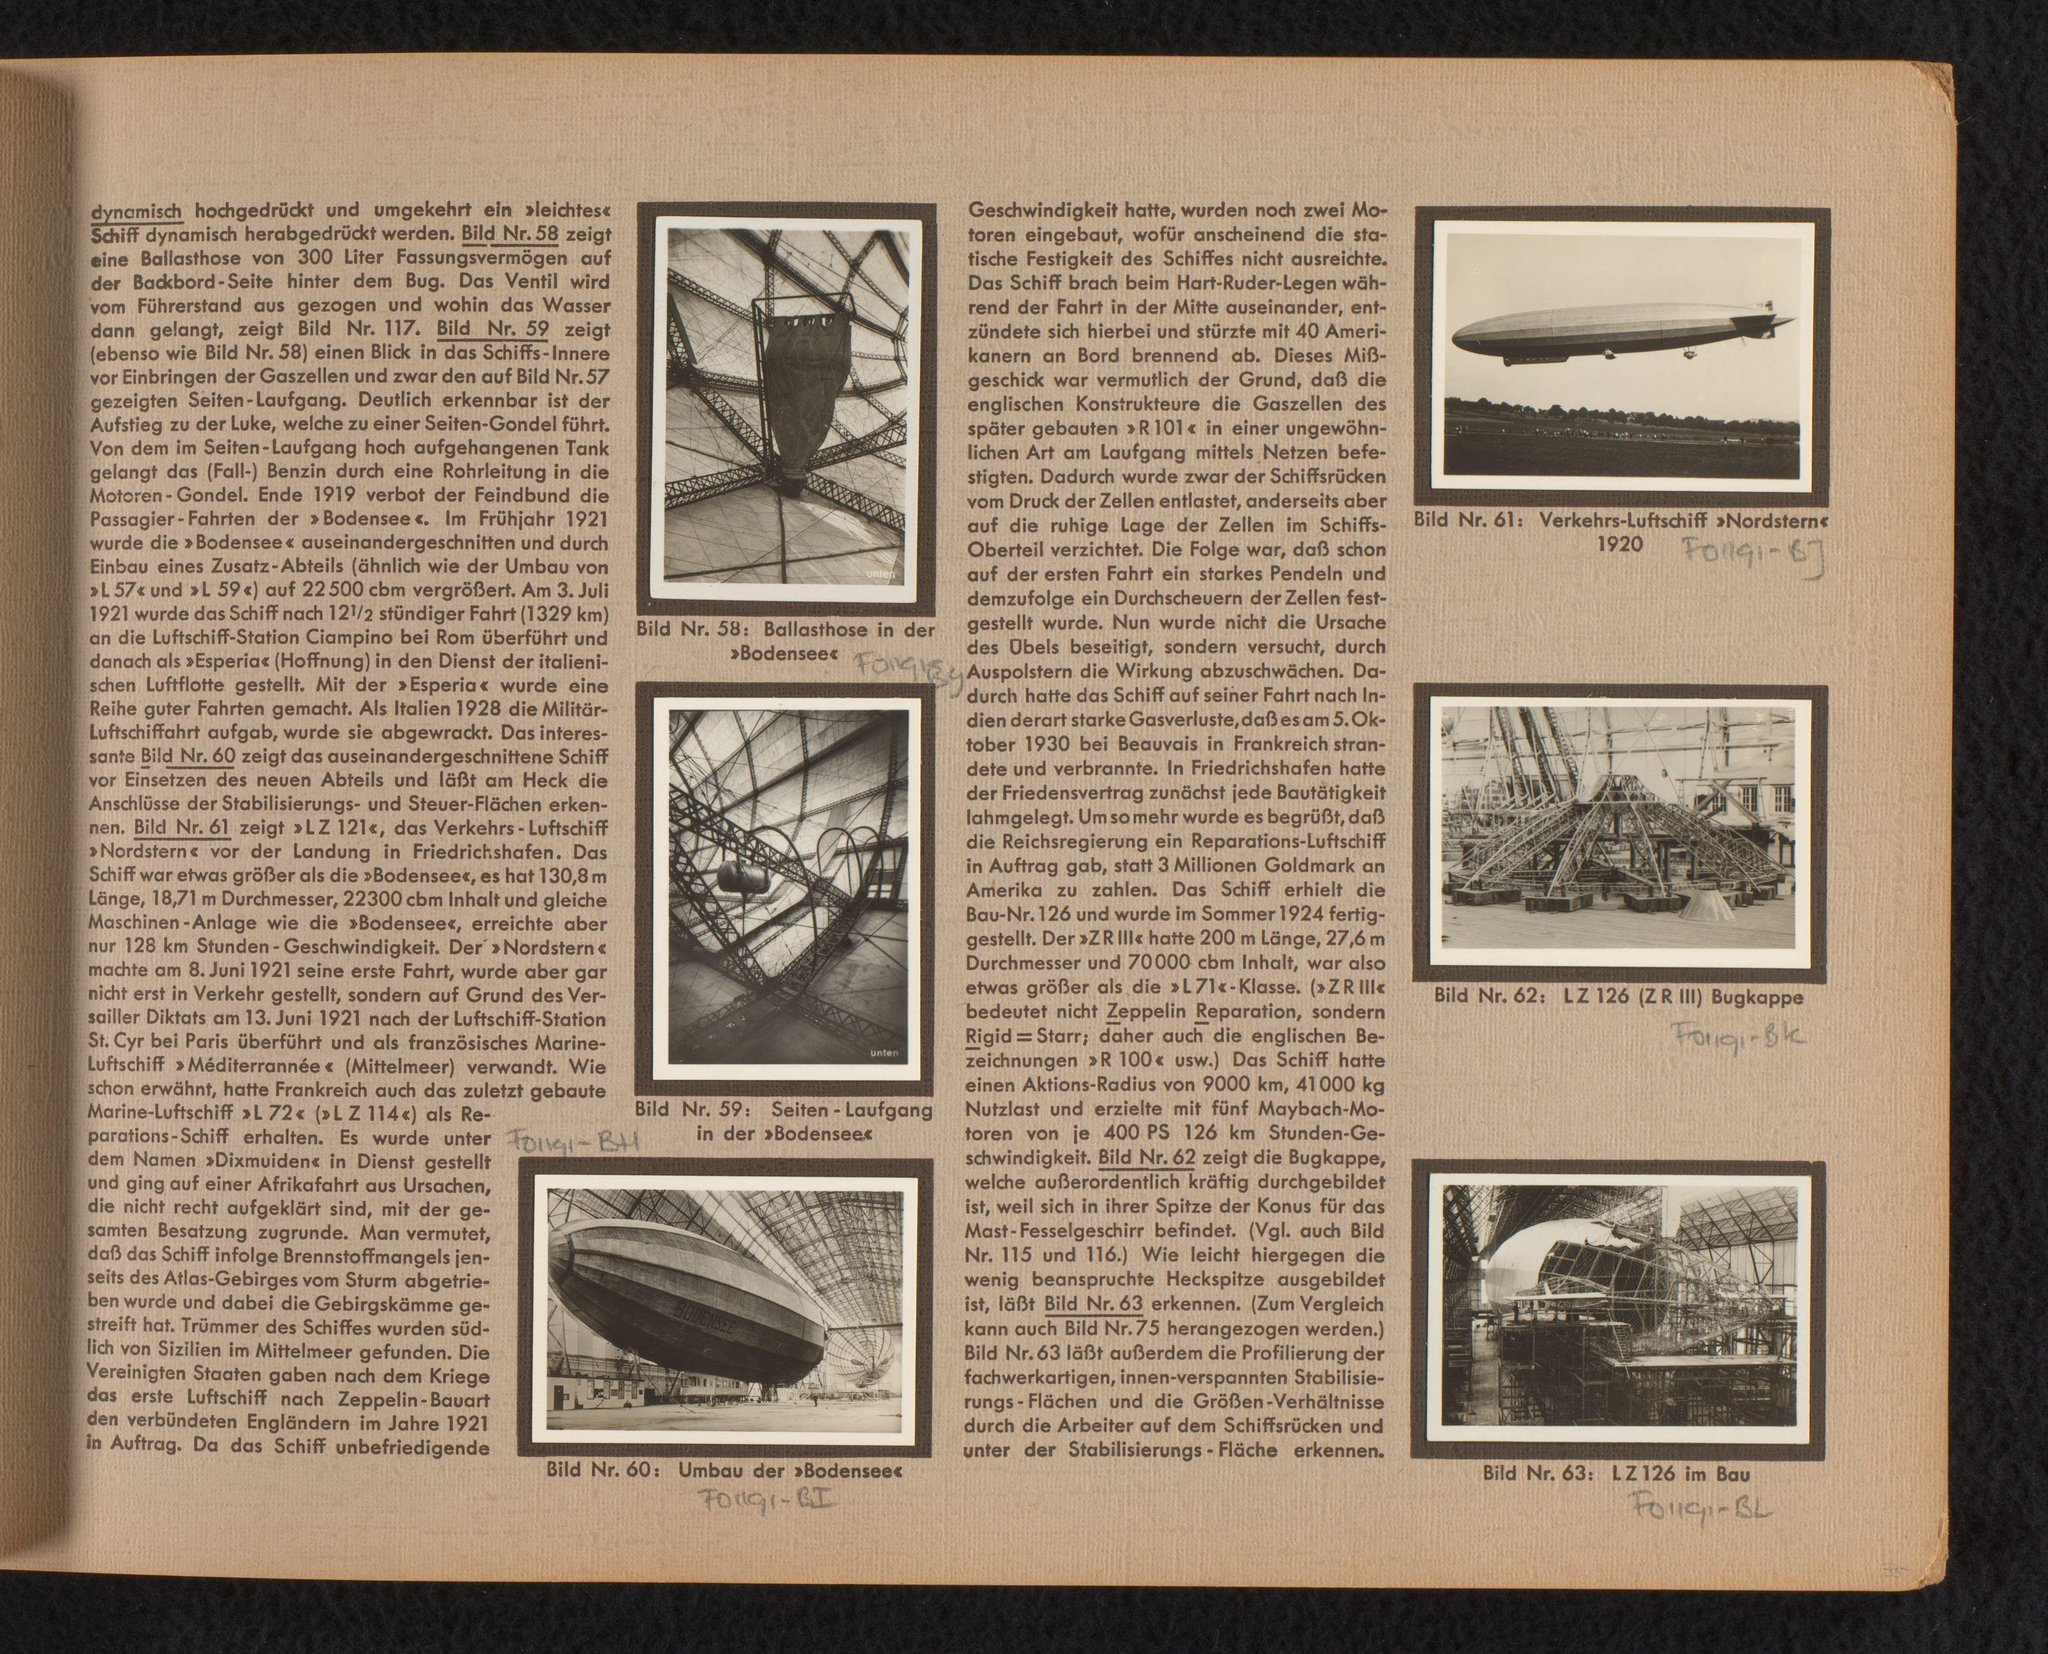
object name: album leaf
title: Verschillende onderdelen van een zeppelin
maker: Anonymous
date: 1919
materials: paper, photographic support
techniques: gelatin silver print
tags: 46c35 airship, zeppelin, historical persons, germany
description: Zes foto's van onder meer verschillende onderdelen van de zeppelin de Bodensee. Alle foto's zijn voorzien van een nummer en titel. Deze pagina maakt deel uit van een album.